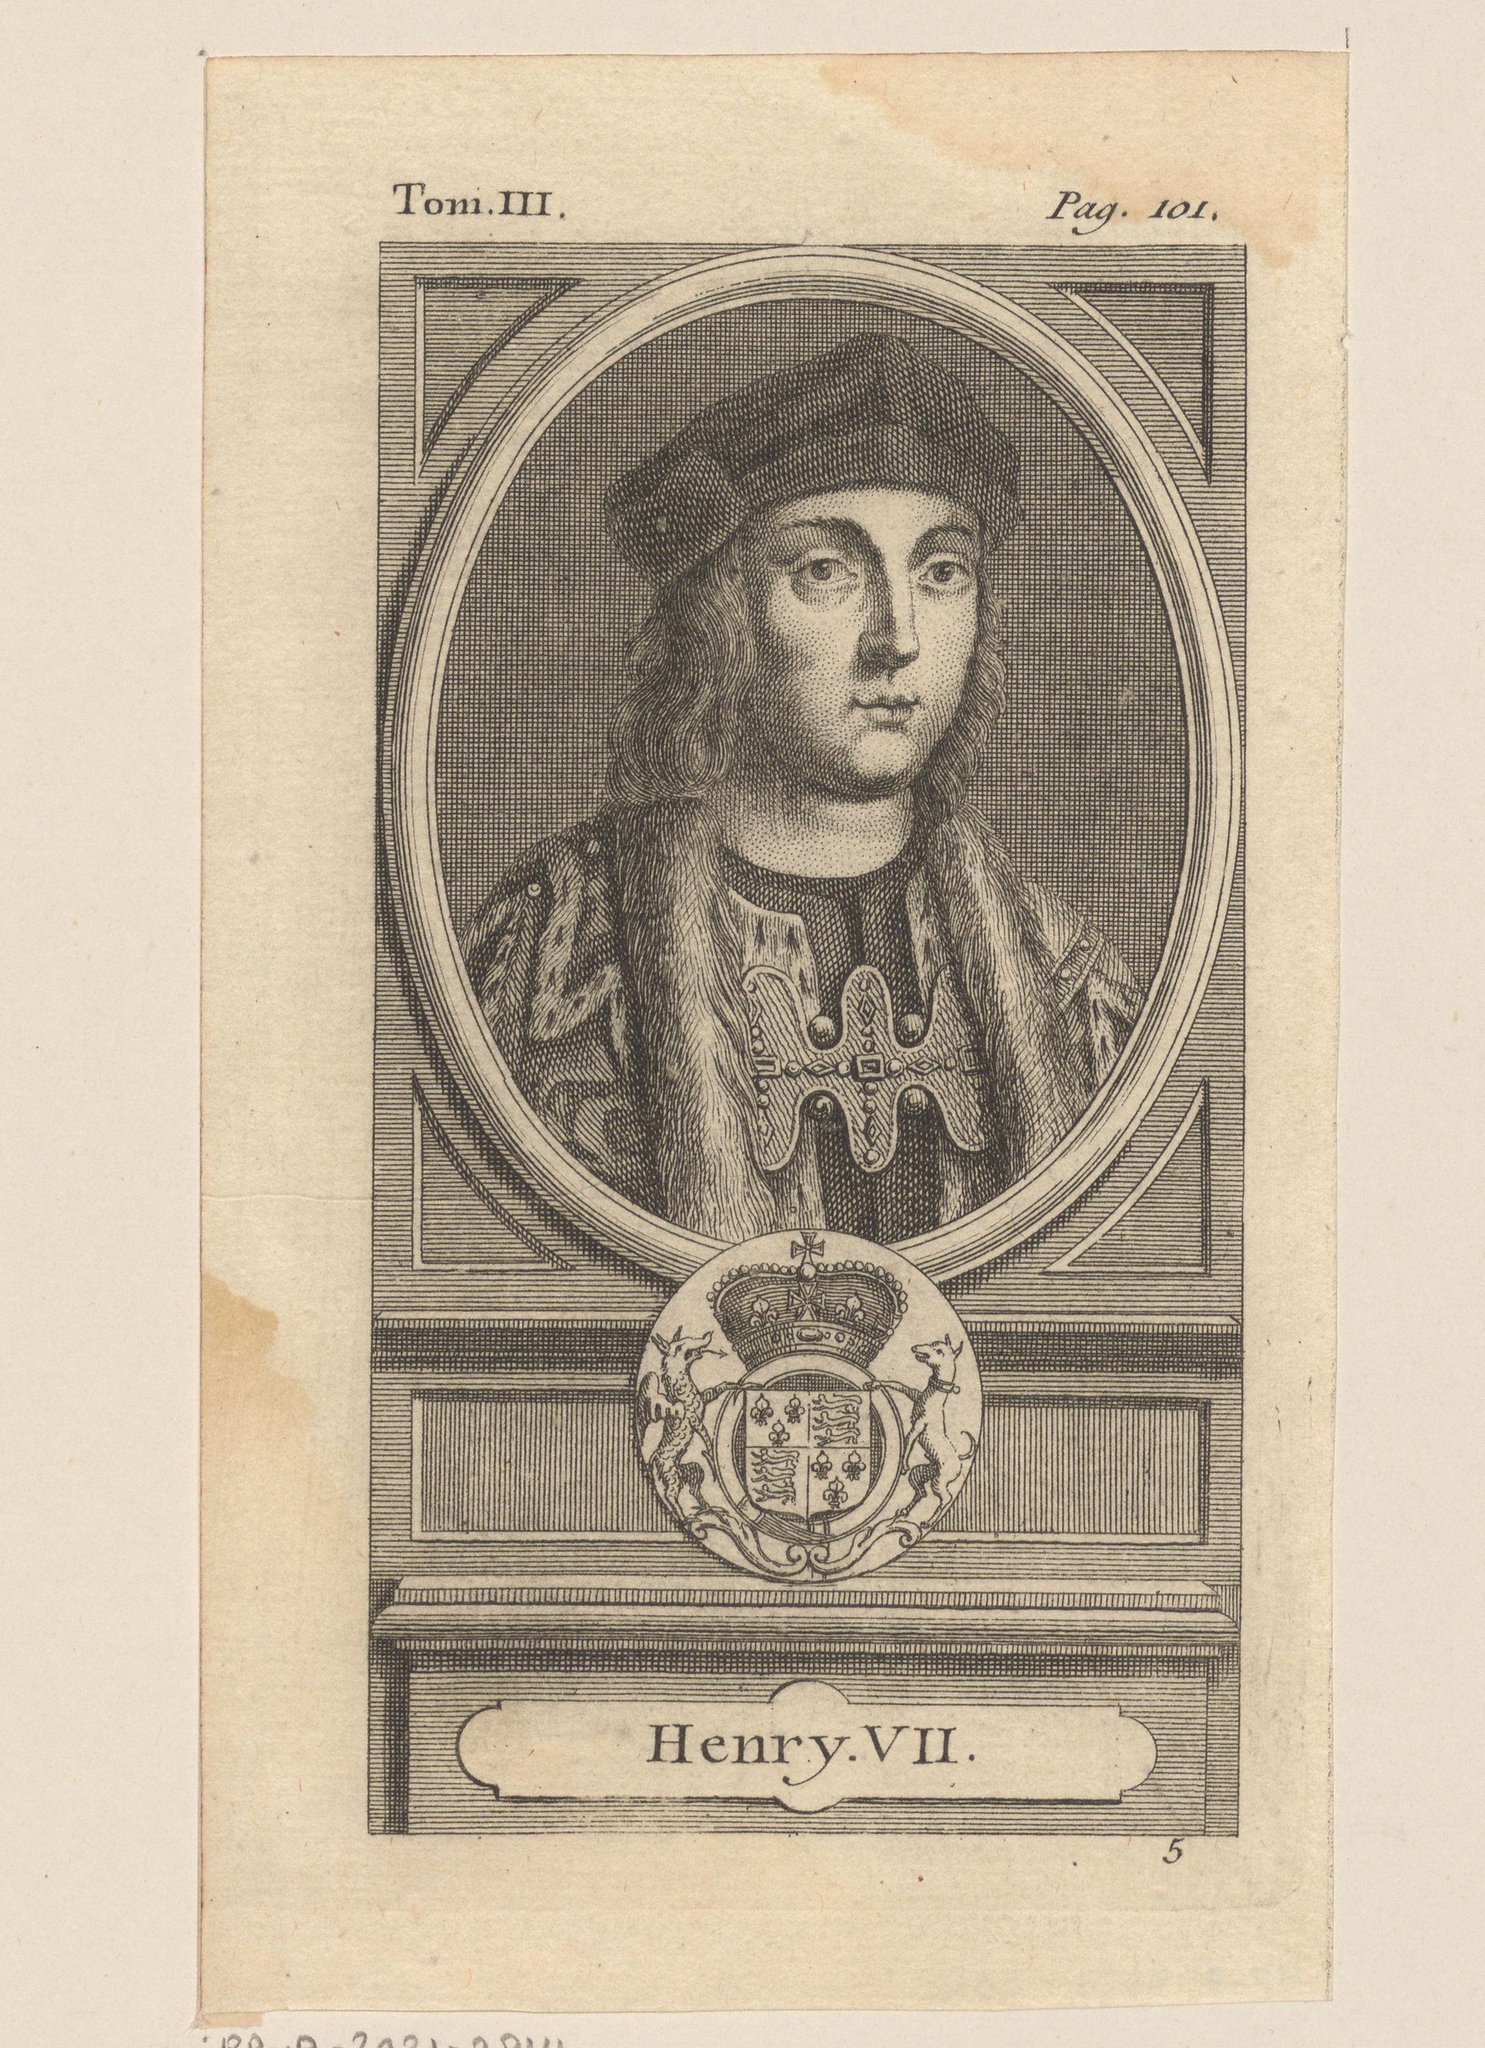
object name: print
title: Portret van Hendrik VII, koning van Engeland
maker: Anonymous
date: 1750-1762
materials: paper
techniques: engraving, etching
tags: historical persons, king, armorial bearing, heraldry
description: Prent gebruikt in: Orleans, Pierre Joseph d’. Histoire des revolutions d'Angleterre, depuis le commencement de la monarchie. Parijs: Pierre-François Giffart en Jacques Rolin, 1750. Prent ook gebruikt in de 1762-editie uitgegeven in Lyon door de gebroeders Duplain. Mogelijk ook gebruikt in andere edities of andere publicaties.